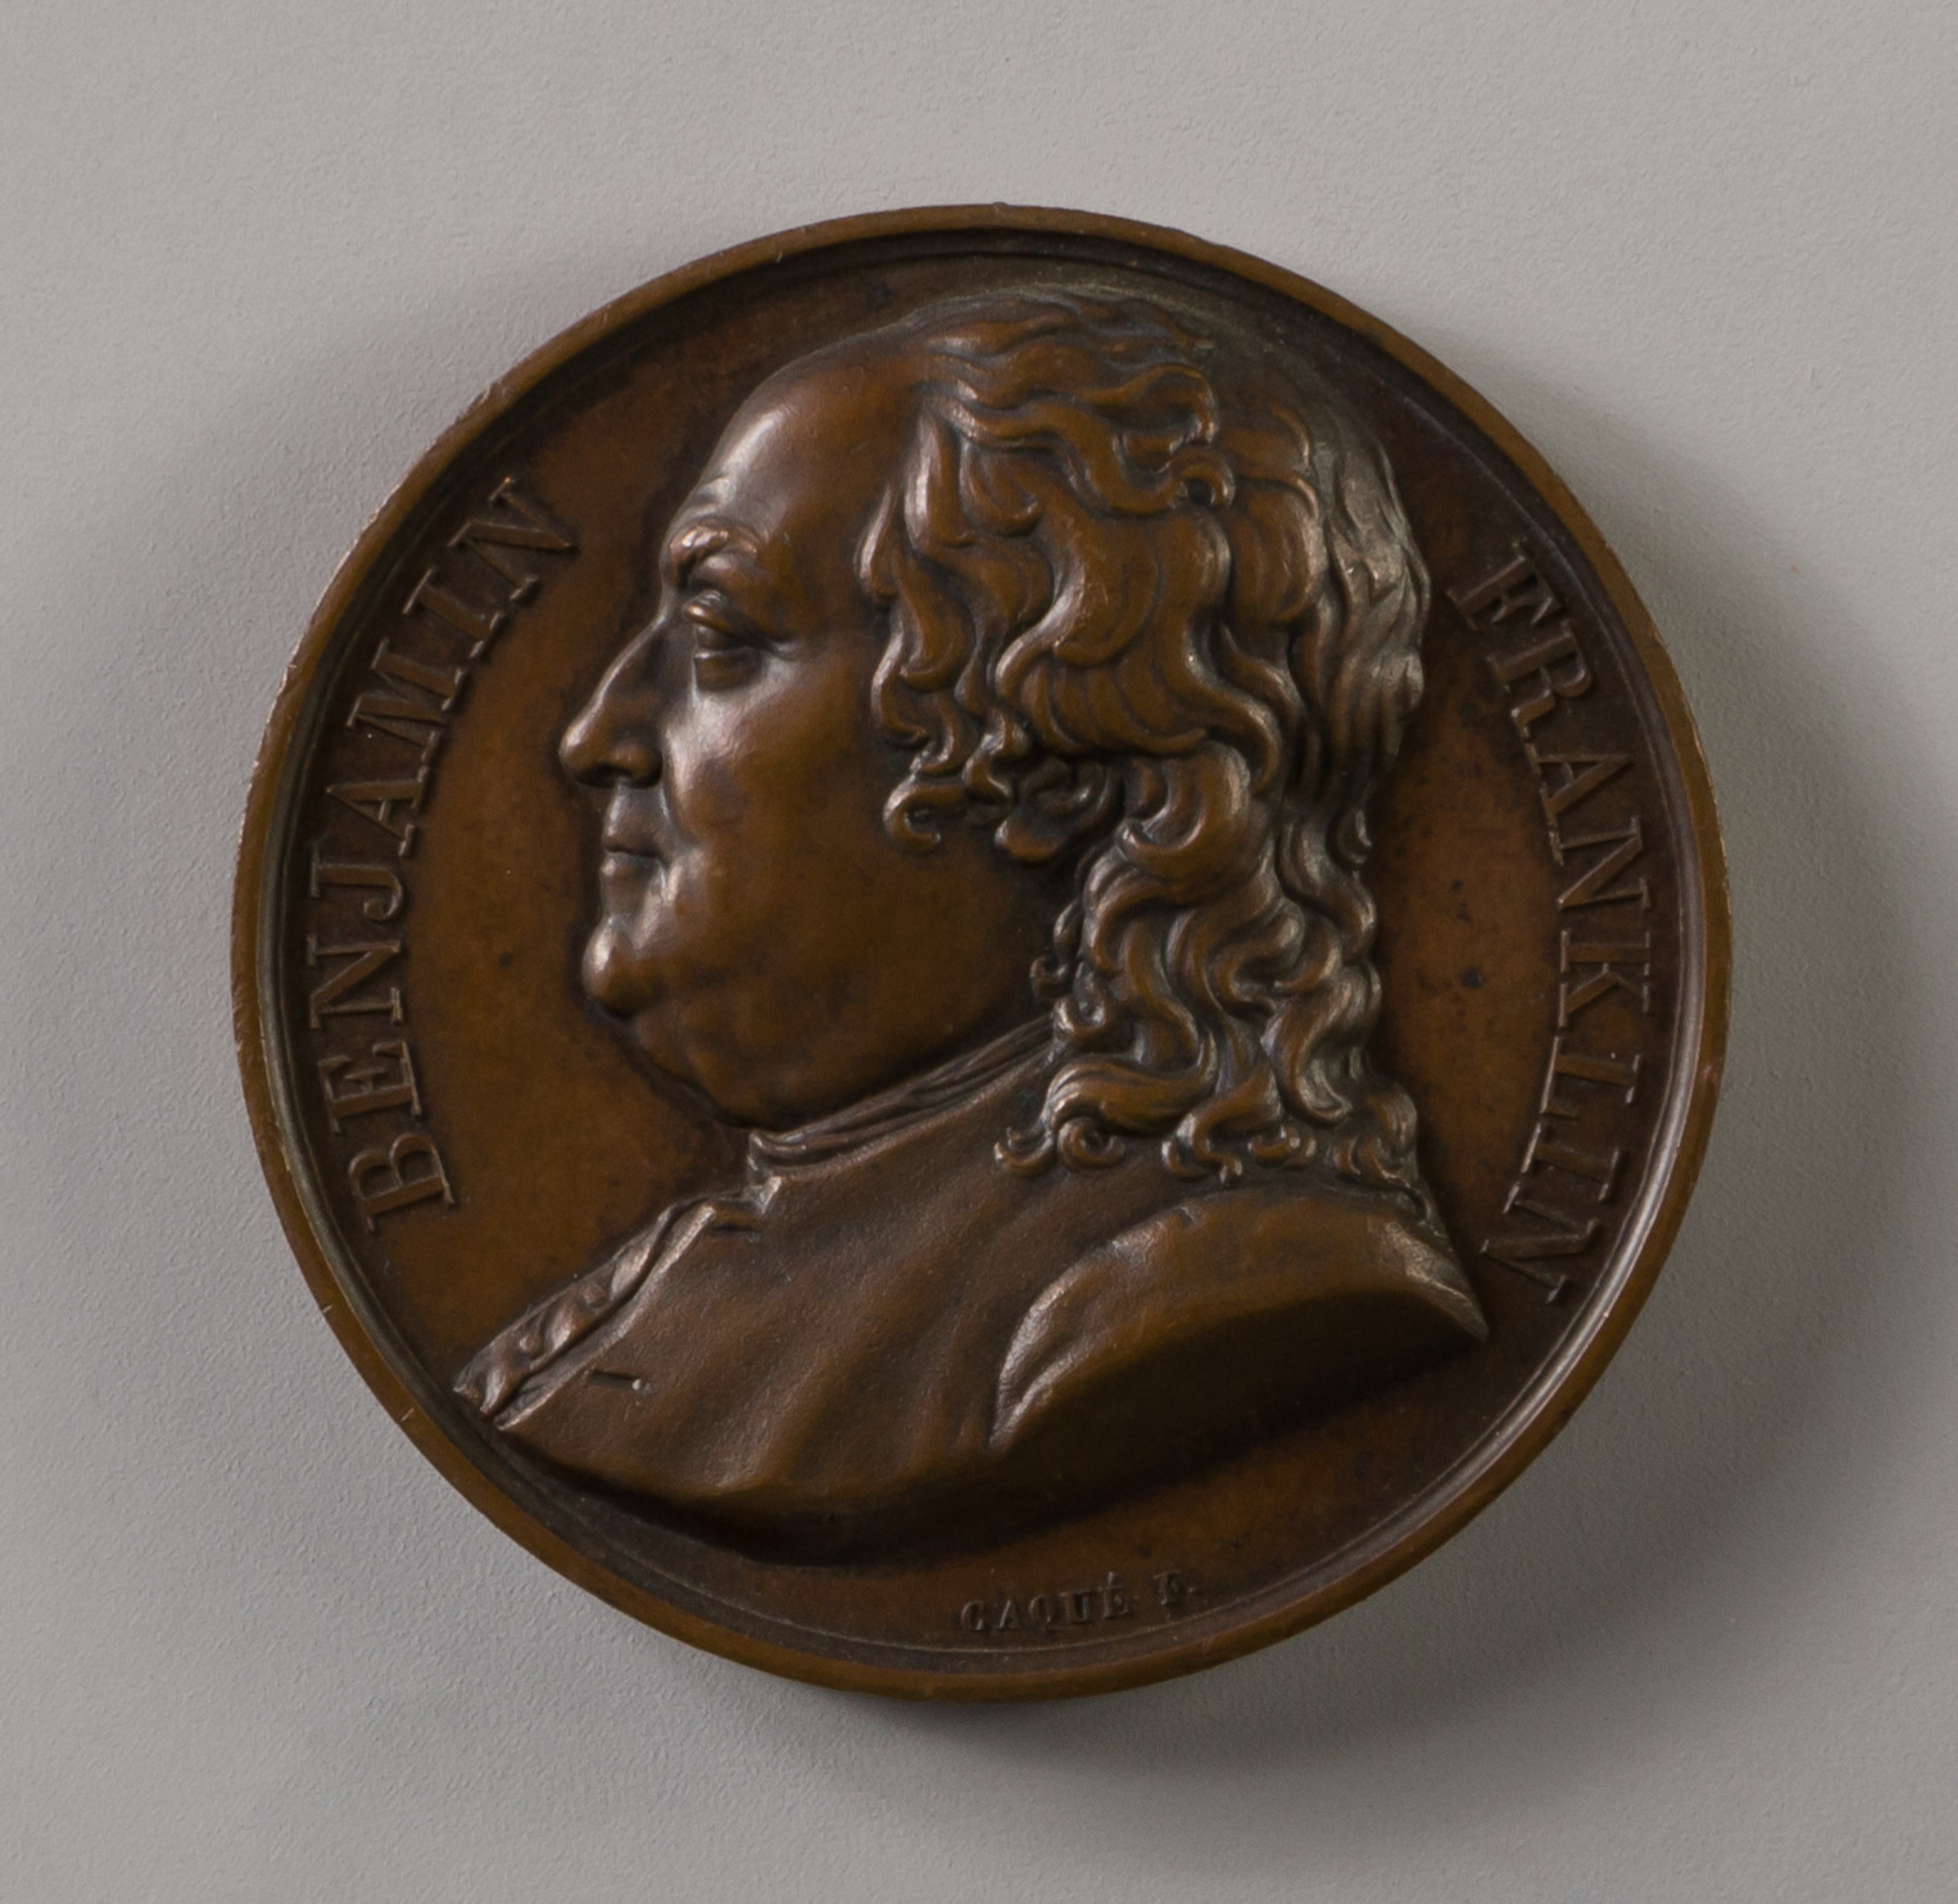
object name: medallion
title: Benjamin Franklin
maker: armand-auguste caqué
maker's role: maker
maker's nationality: french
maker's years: 1793-1881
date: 1818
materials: gilt bronze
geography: france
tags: benjamin franklin,profiles